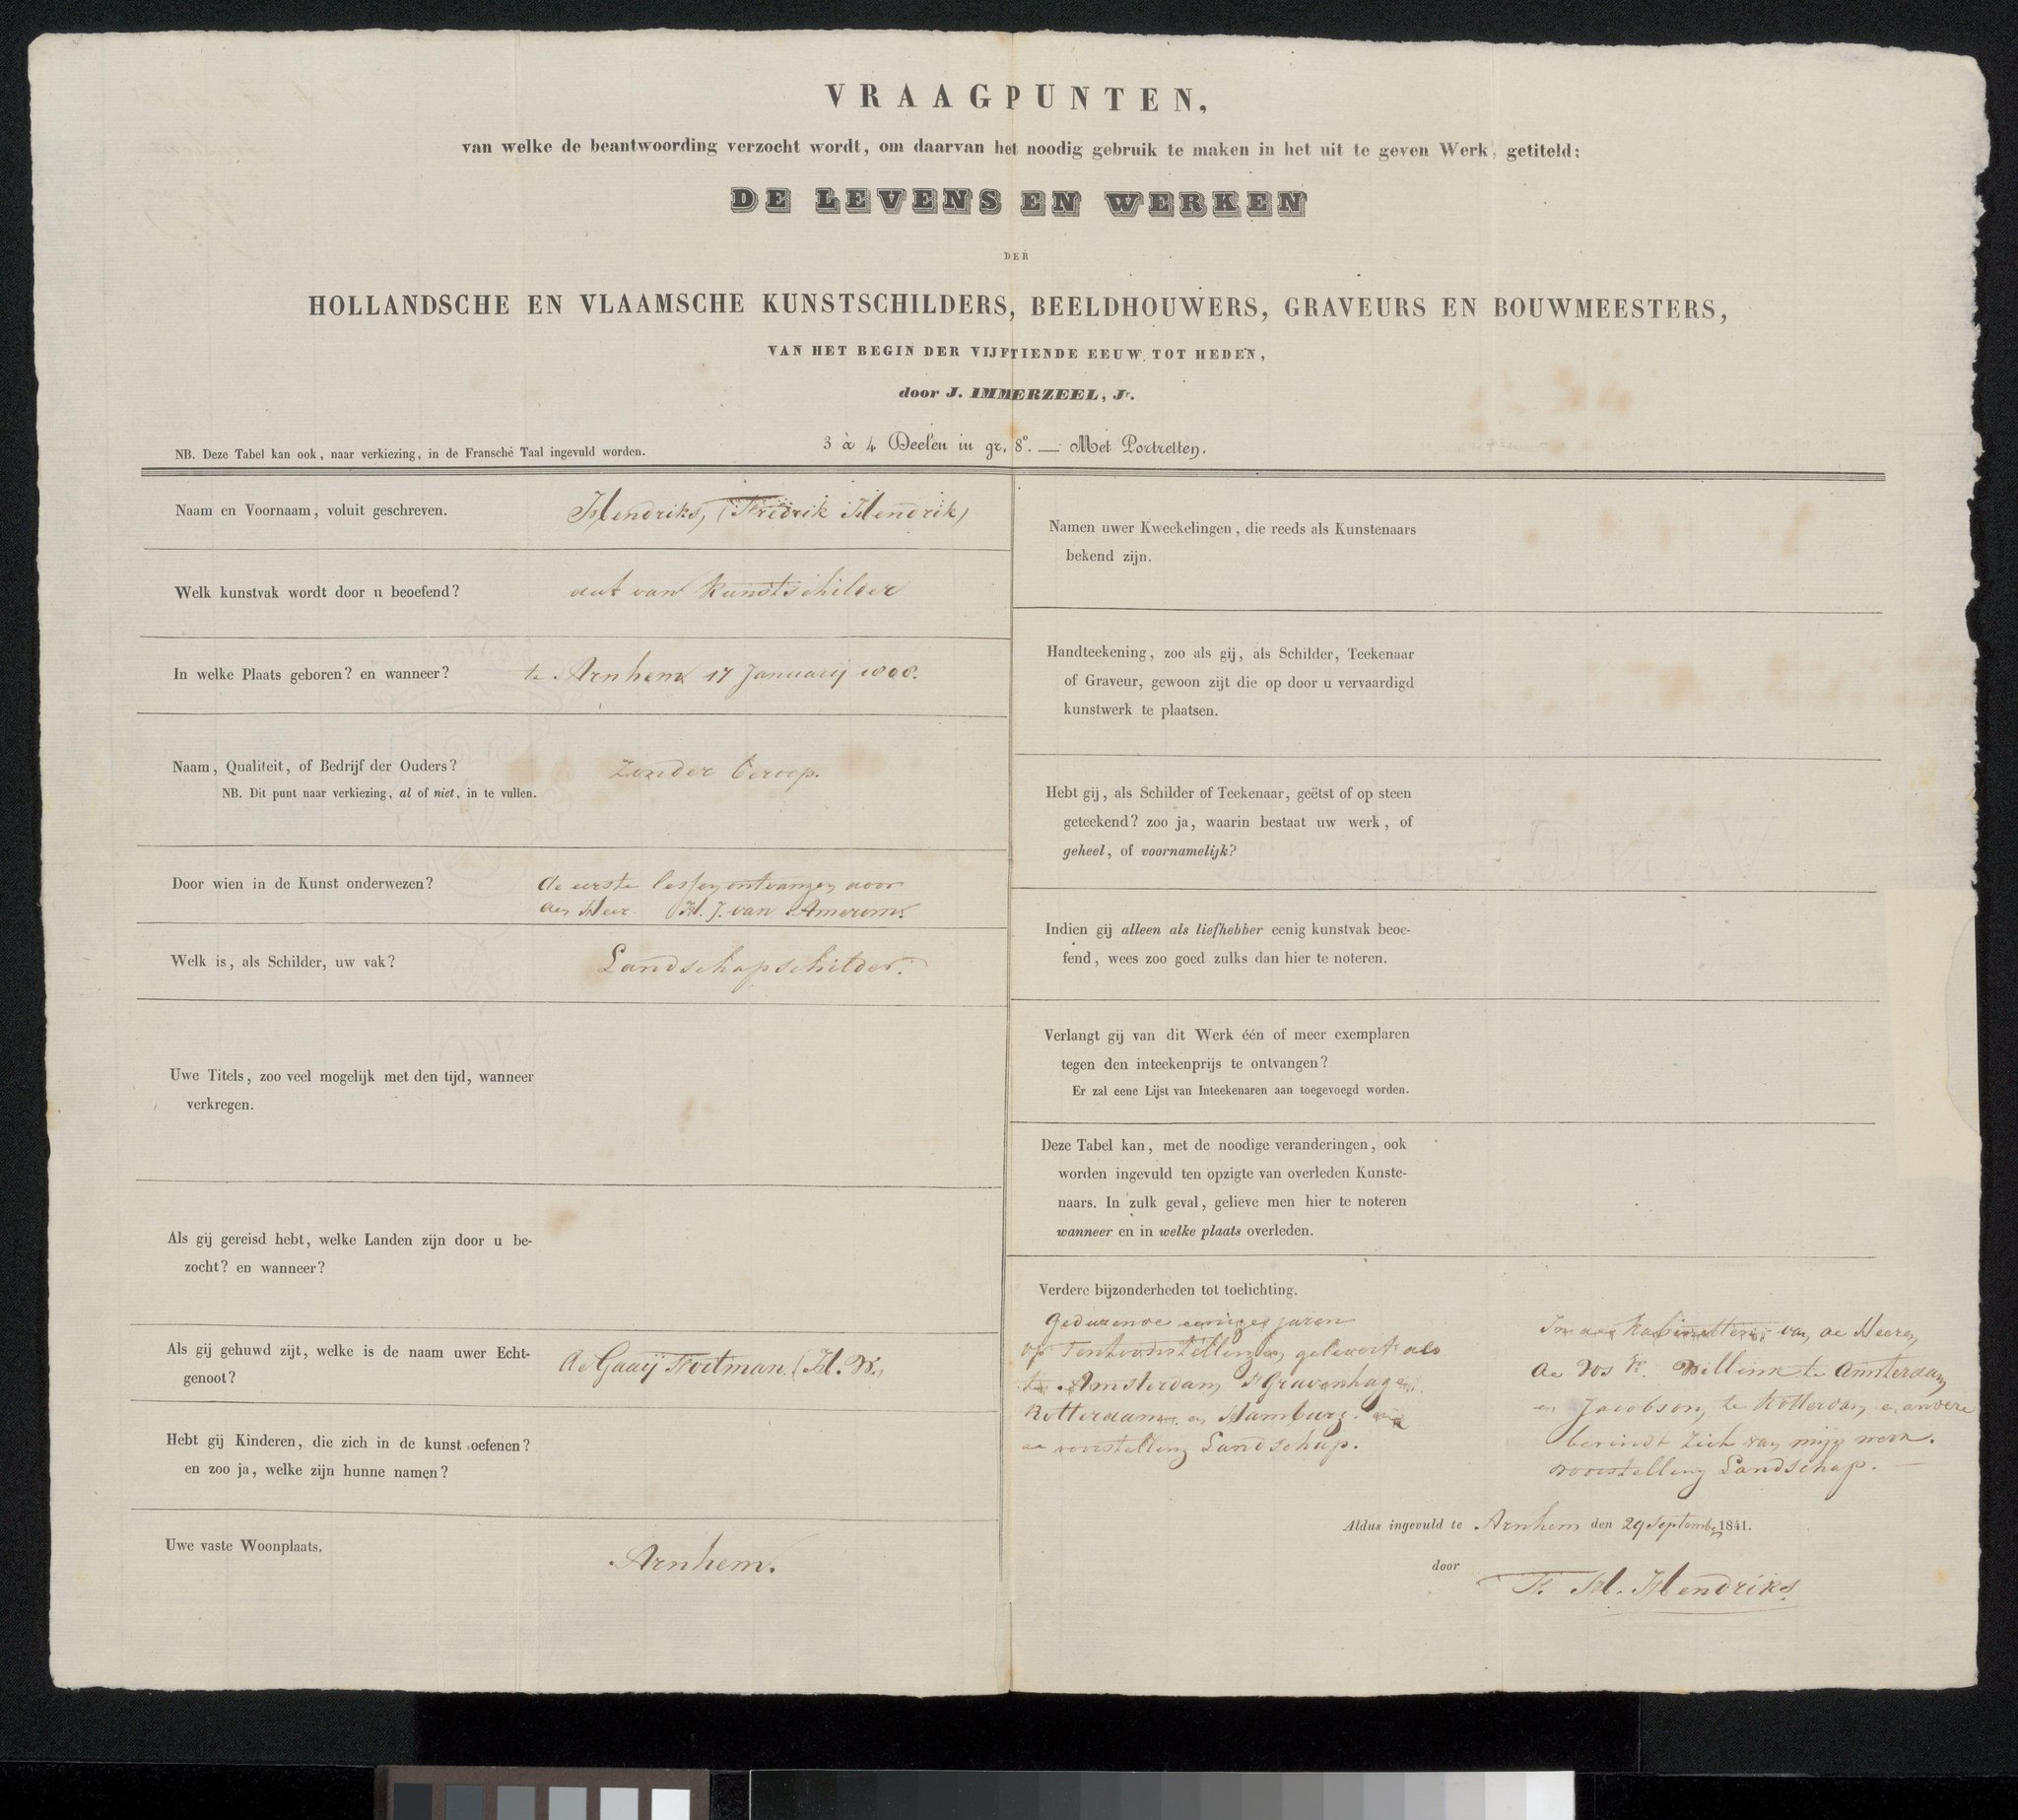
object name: questionnaire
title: Enquêteformulier ingevuld door Frederik Hendrik Hendriks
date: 1841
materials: ink, paper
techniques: pen, printing, writing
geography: arnhem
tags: arnhem, painter, frederik hendrik hendriks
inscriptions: watermark, inscription: ‘Vraagpunten,/ van welke de beantwoording verzocht wordt, om daarvan het noodig gebruik te maken in het uit te geven Werk, getiteld: De levens en werken/ der Hollandsche en Vlaamsche kunstschilders, beeldhouwers,/ graveurs en bouwmeesters, van het begin der vijftiende eeuw tot heden/ door J. Immerzeel, Jr.’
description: Opgenomen in: Immerzeel, J. Jr., De levens en werken der Hollandsche en Vlaamsche kunstschilders, beeldhouwers, graveurs en bouwmeesters, van het begin der vijftiende eeuw tot heden, Amsterdam: J.C. van Kesteren, 1842-1843.